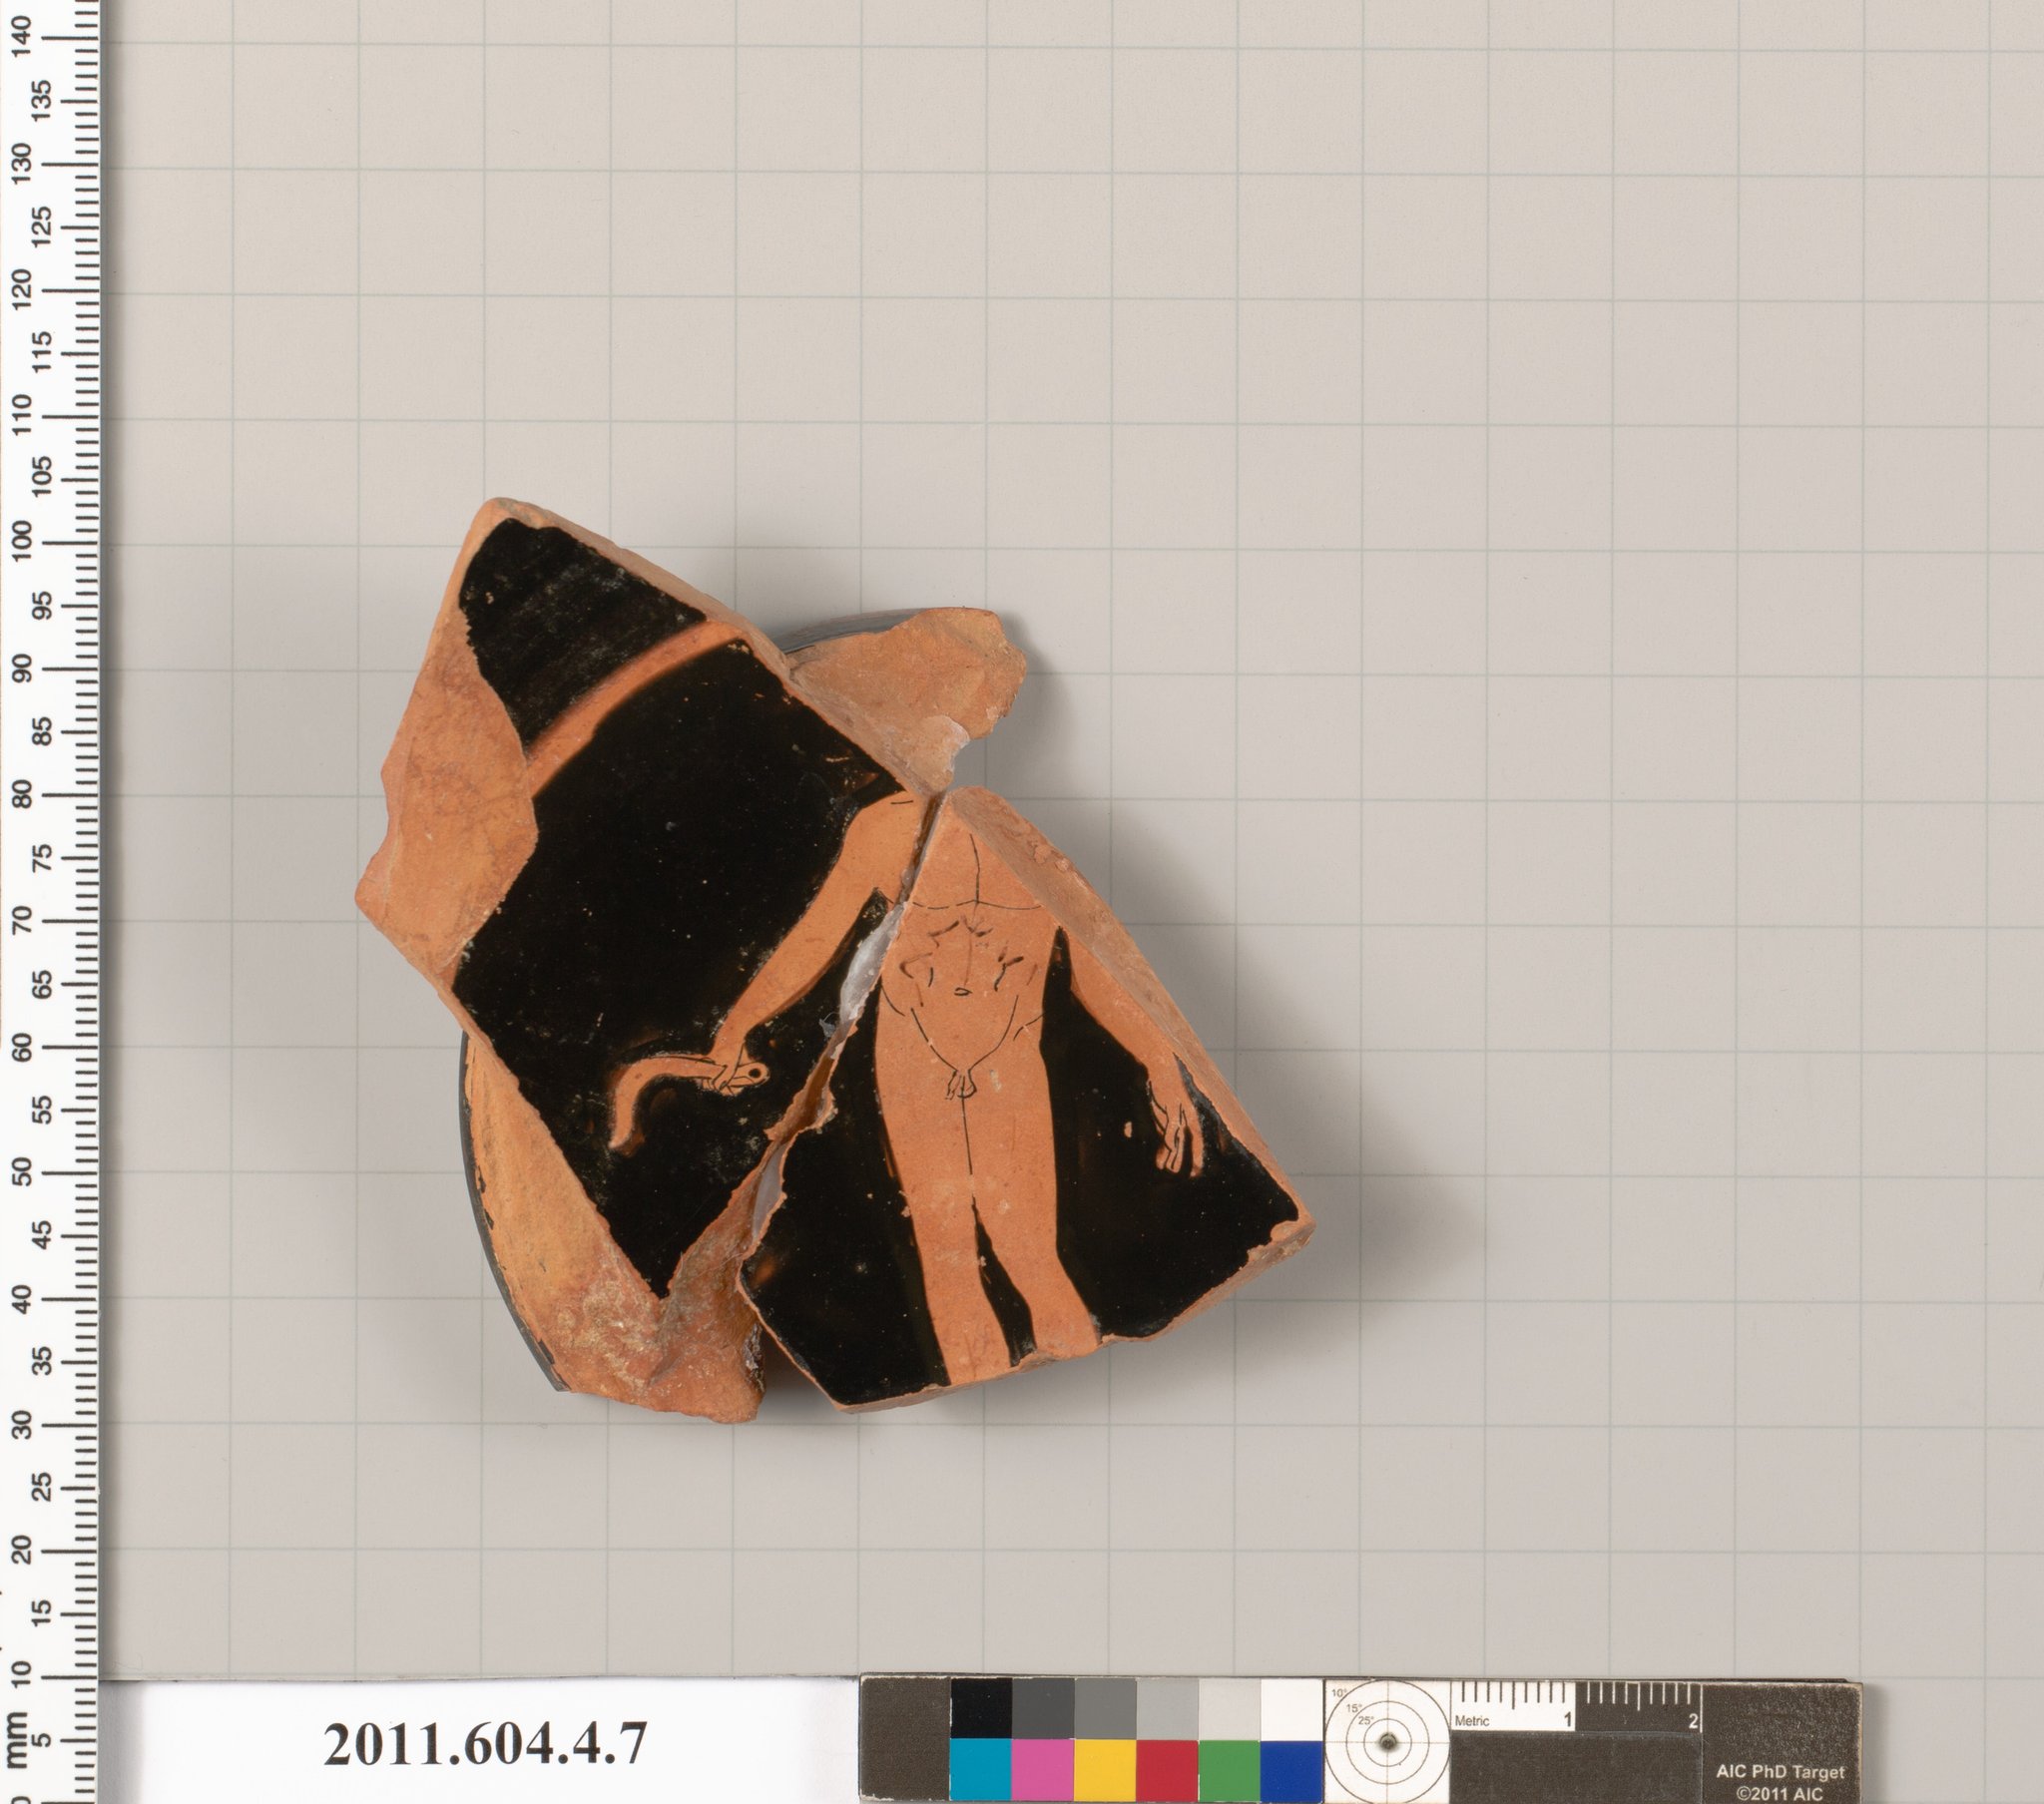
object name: kylix fragment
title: Terracotta fragment of a stemless kylix (drinking cup)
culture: greek, attic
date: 467-435 BCE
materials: terracotta